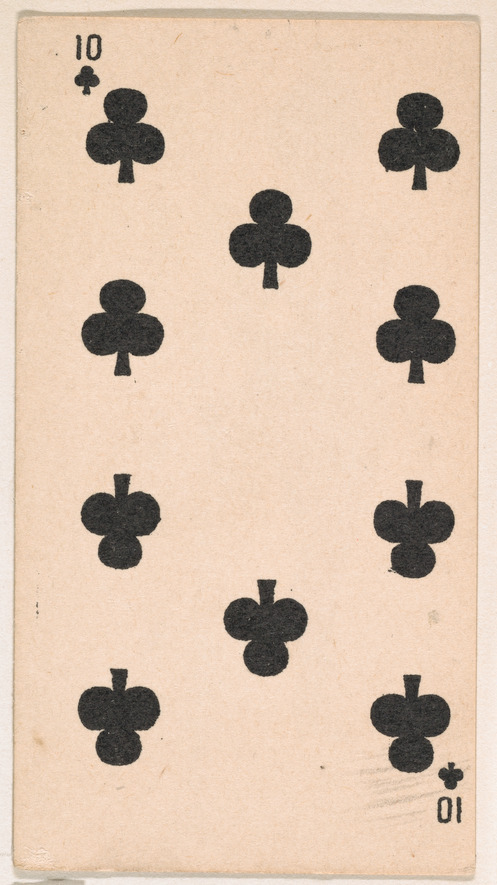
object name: print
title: Ten of Clubs, from the Transparent Playing Cards series (N220) issued by Kinney Bros.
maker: kinney brothers tobacco company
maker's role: publisher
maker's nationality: american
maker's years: 1869-2011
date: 1888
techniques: color lithograph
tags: playing cards